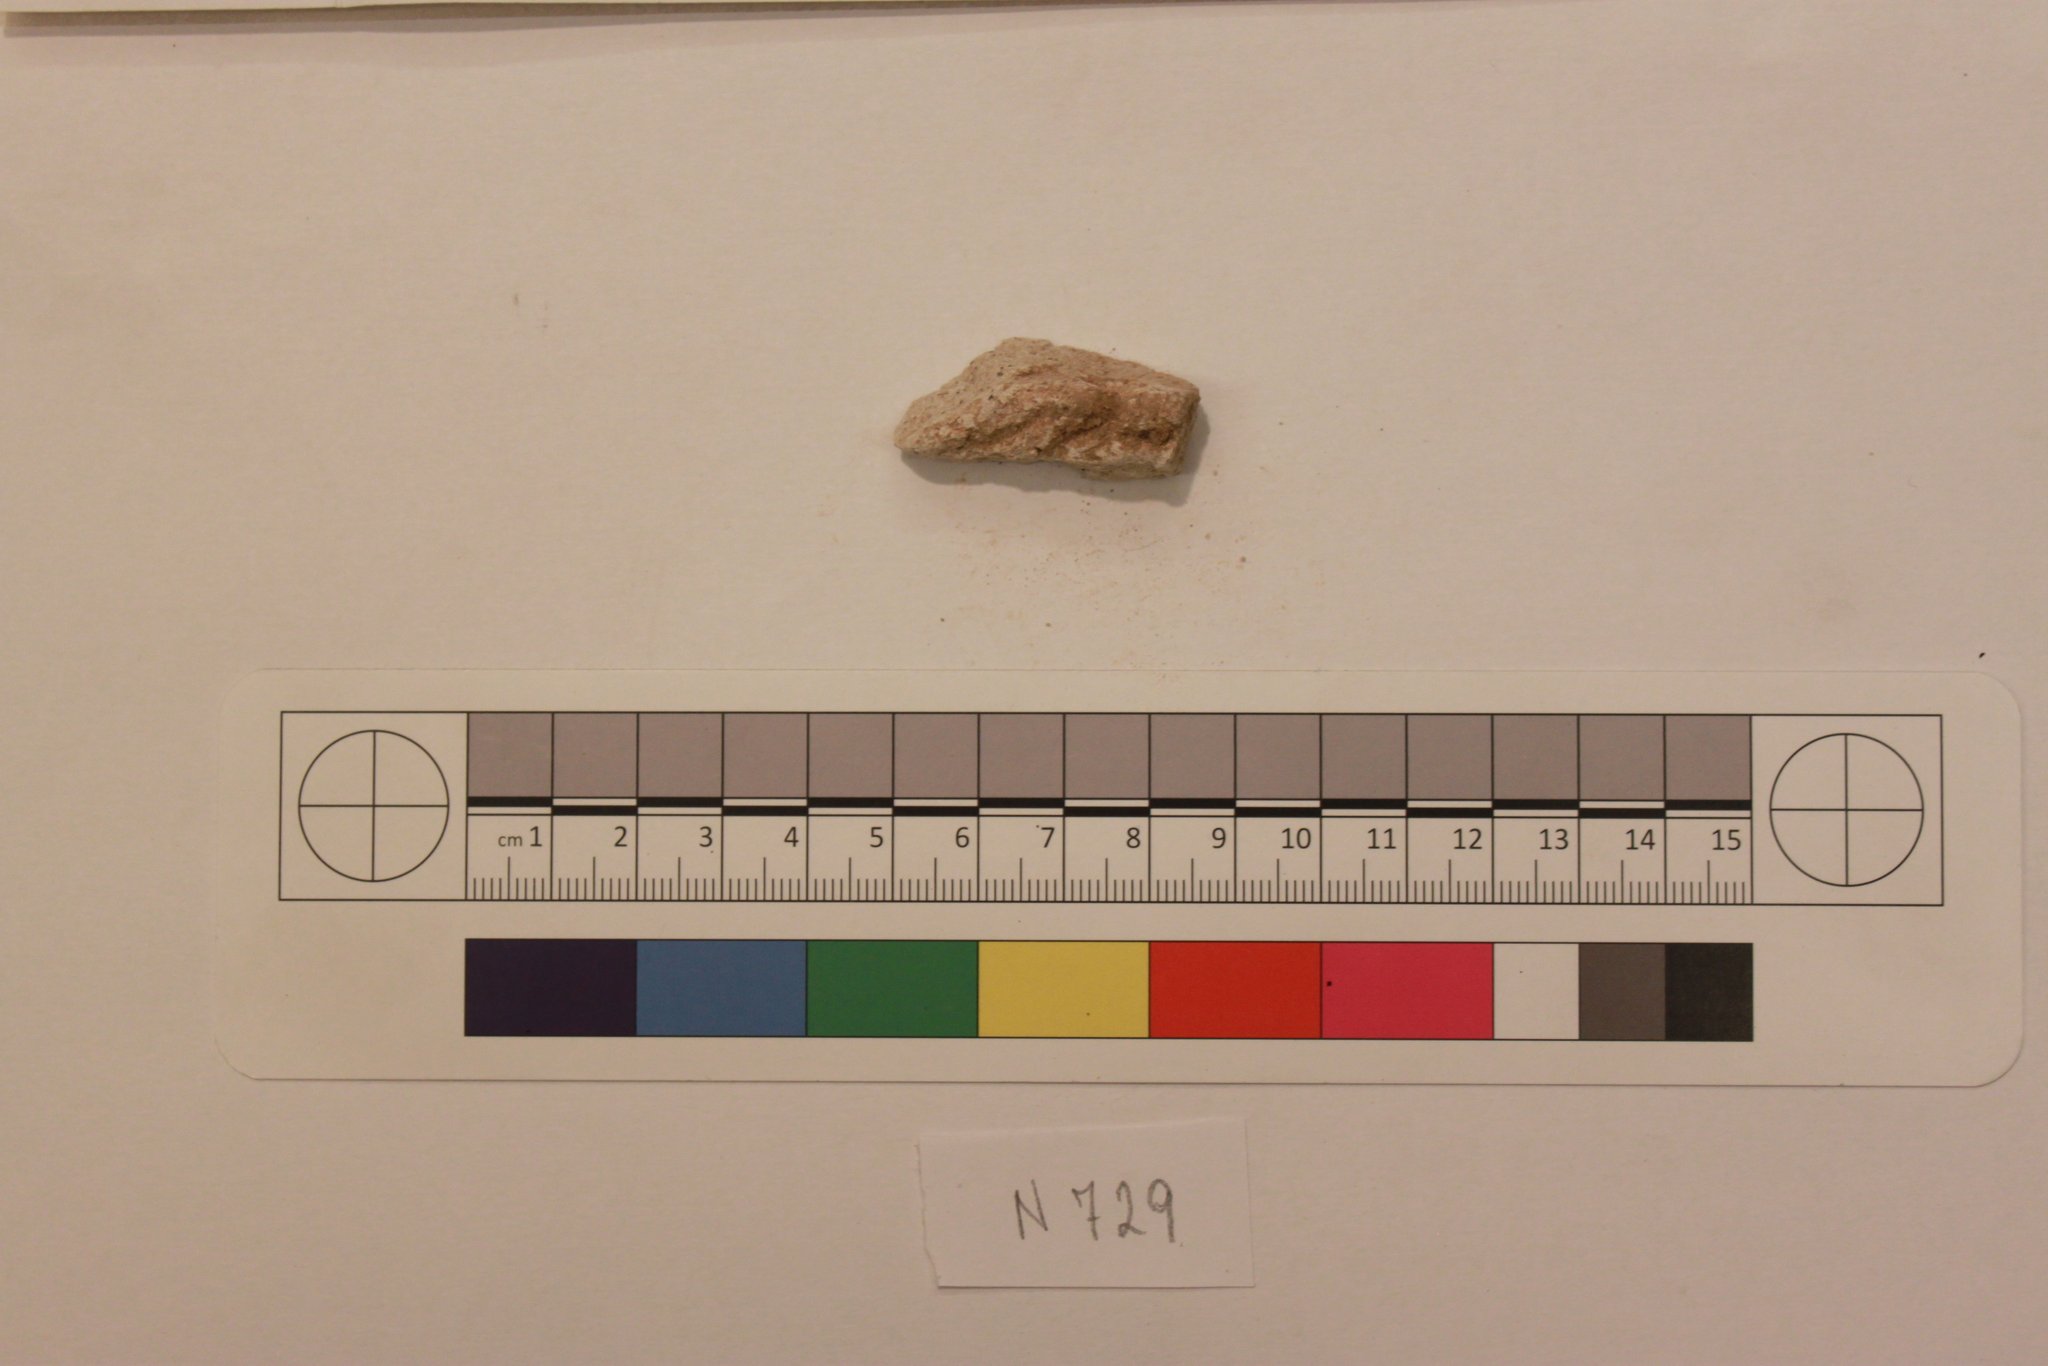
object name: fragment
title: Stucco Fragment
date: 701-1200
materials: plaster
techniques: carving, painting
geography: iran